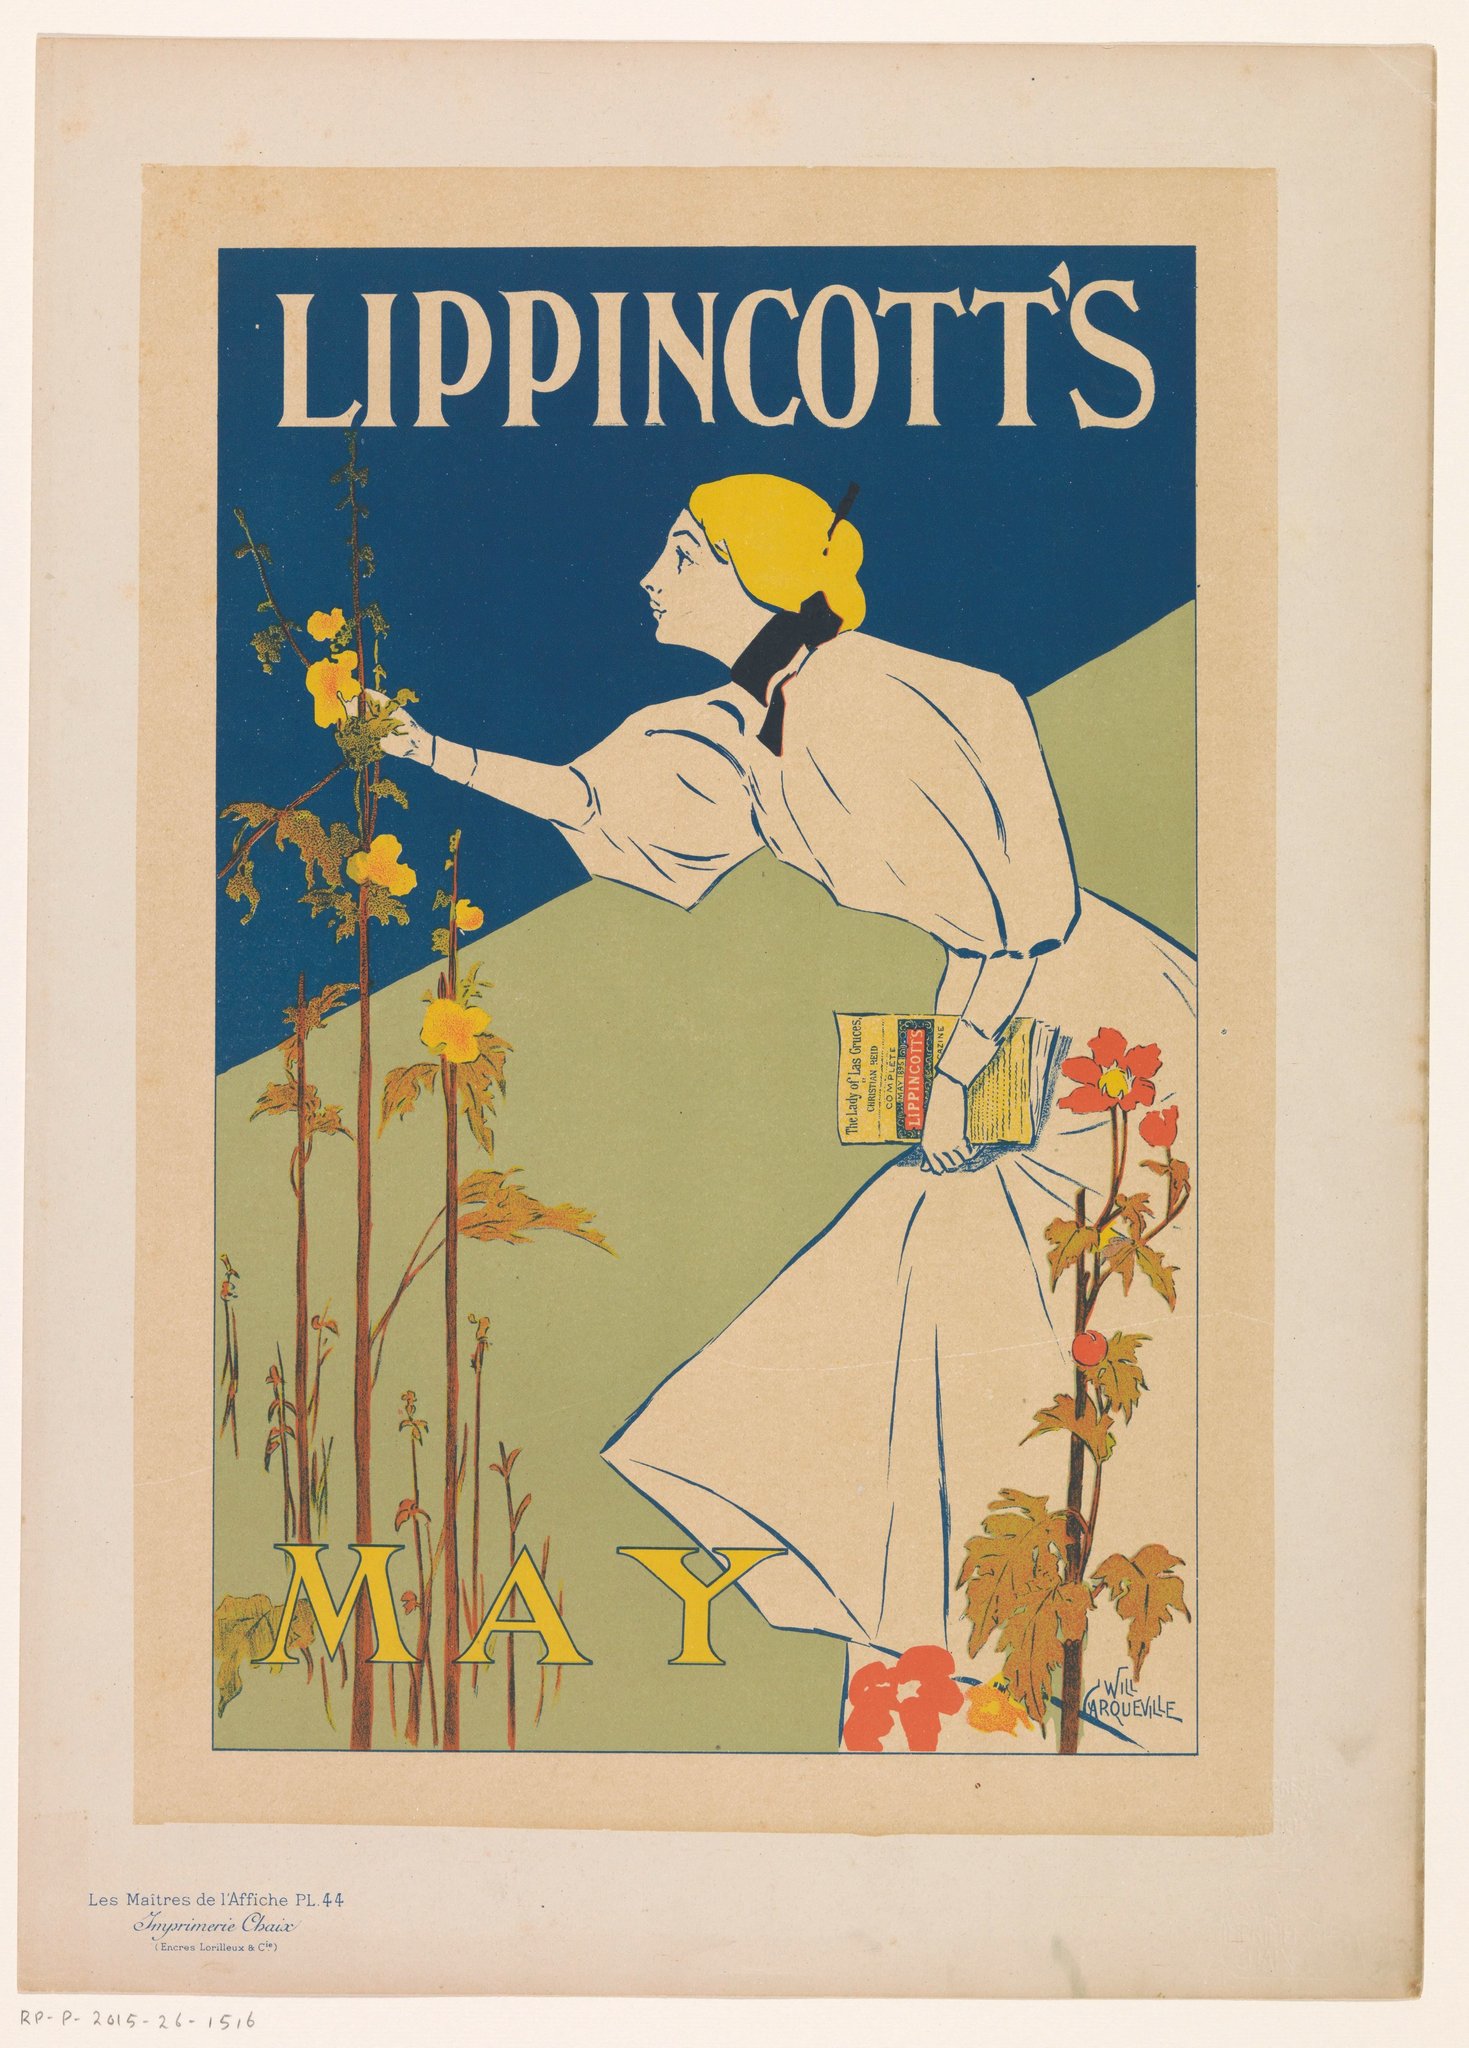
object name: print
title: Les Maîtres de l'Affiche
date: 1895-1900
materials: paper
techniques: lithograph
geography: paris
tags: picking flowers, weekly, monthly, magazine, etc.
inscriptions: stamp: Lugt 1777c, collector's mark: Lugt 4780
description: Een vrouw plukt een bloem, in haar linkerhand een exemplaar van het tijdschrift.